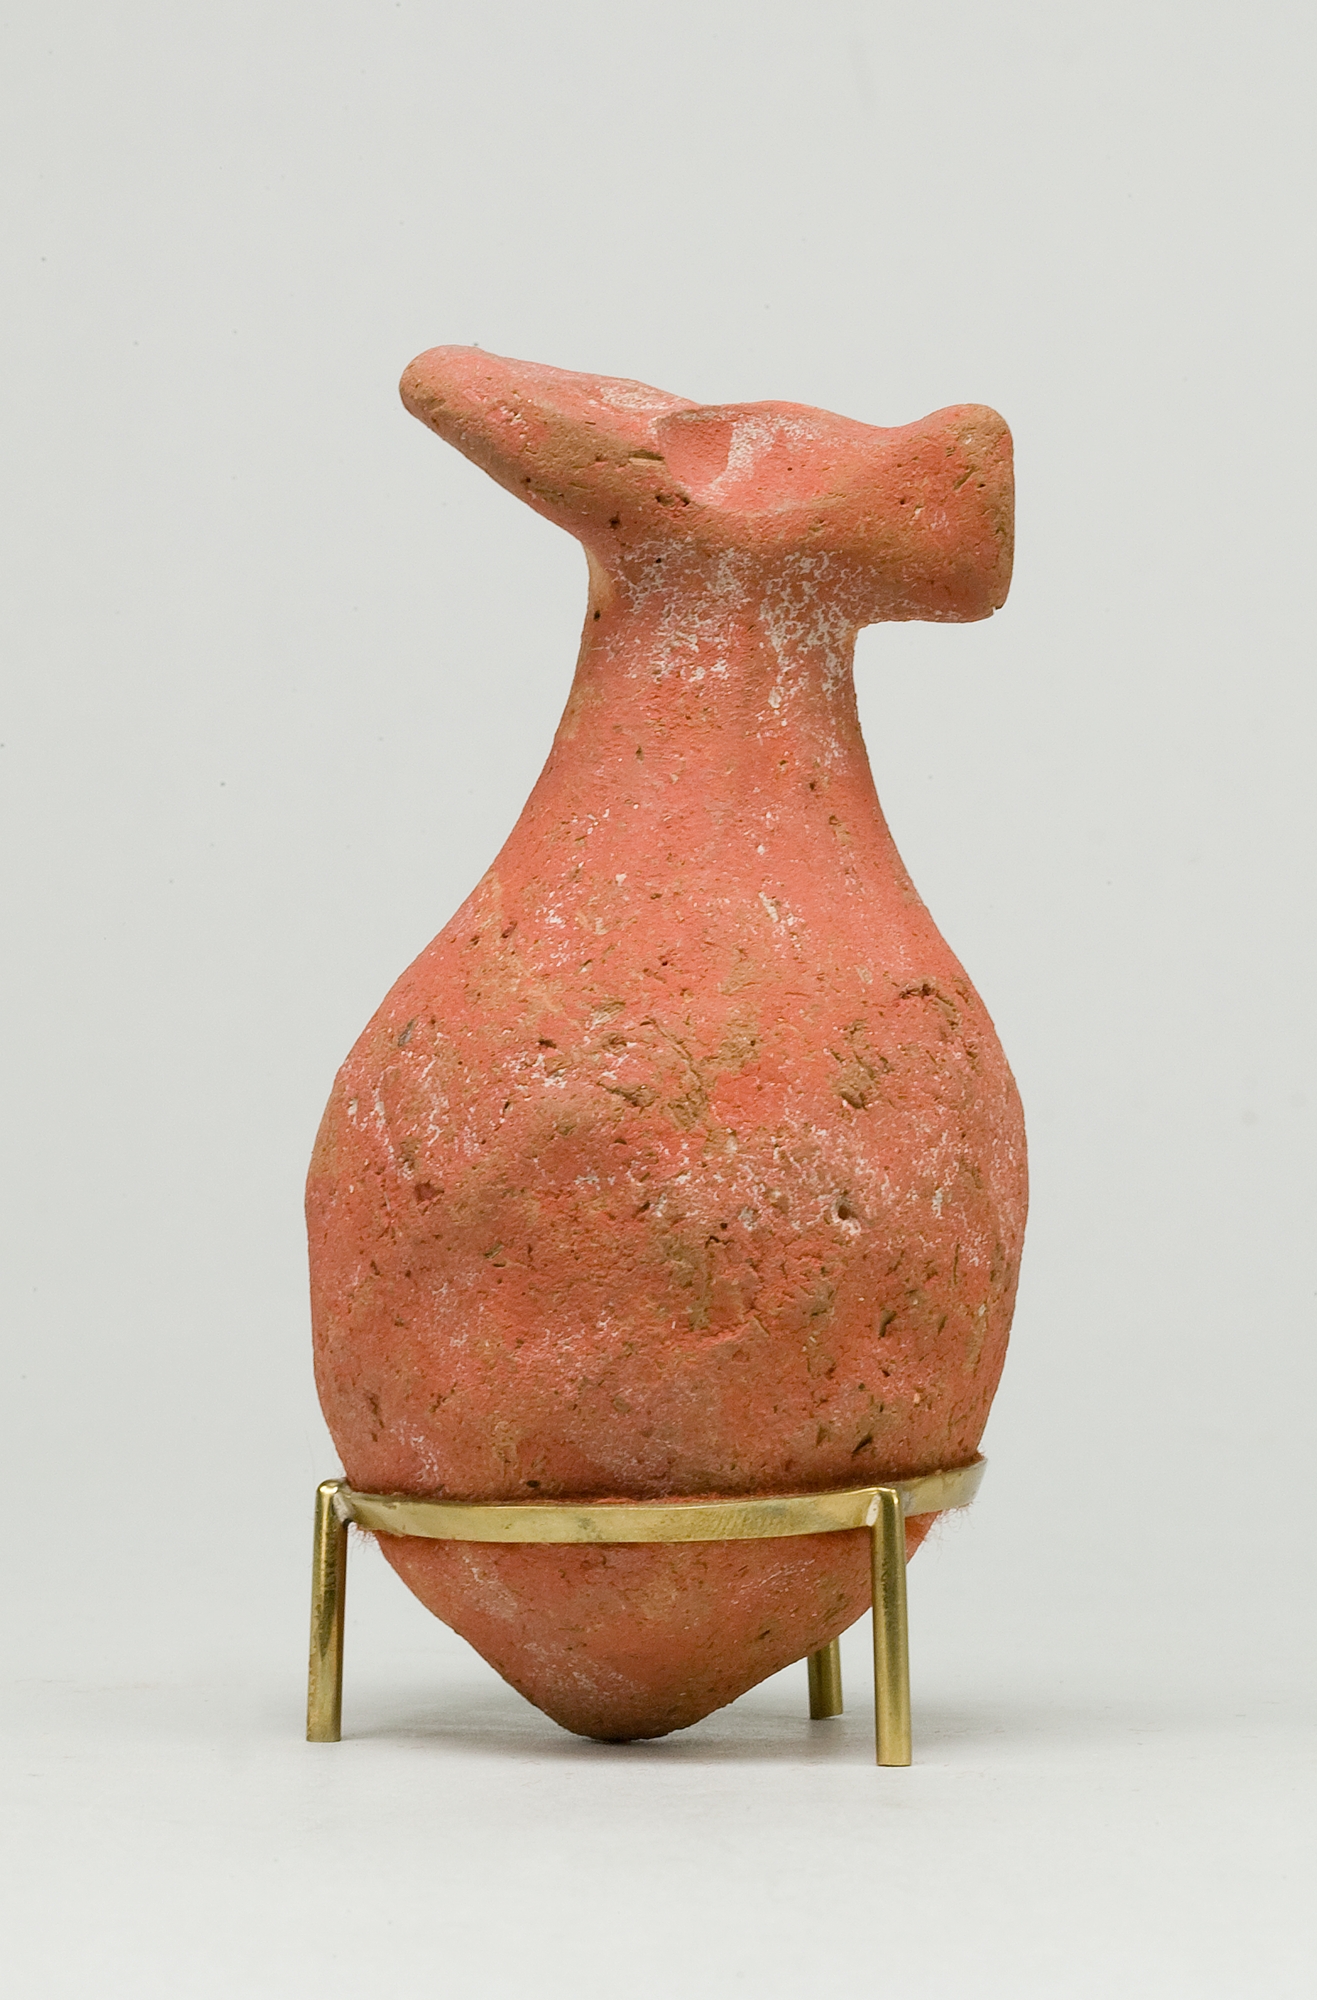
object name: jar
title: Animal-headed Rattle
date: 1981-1550 BCE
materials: pottery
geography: egypt